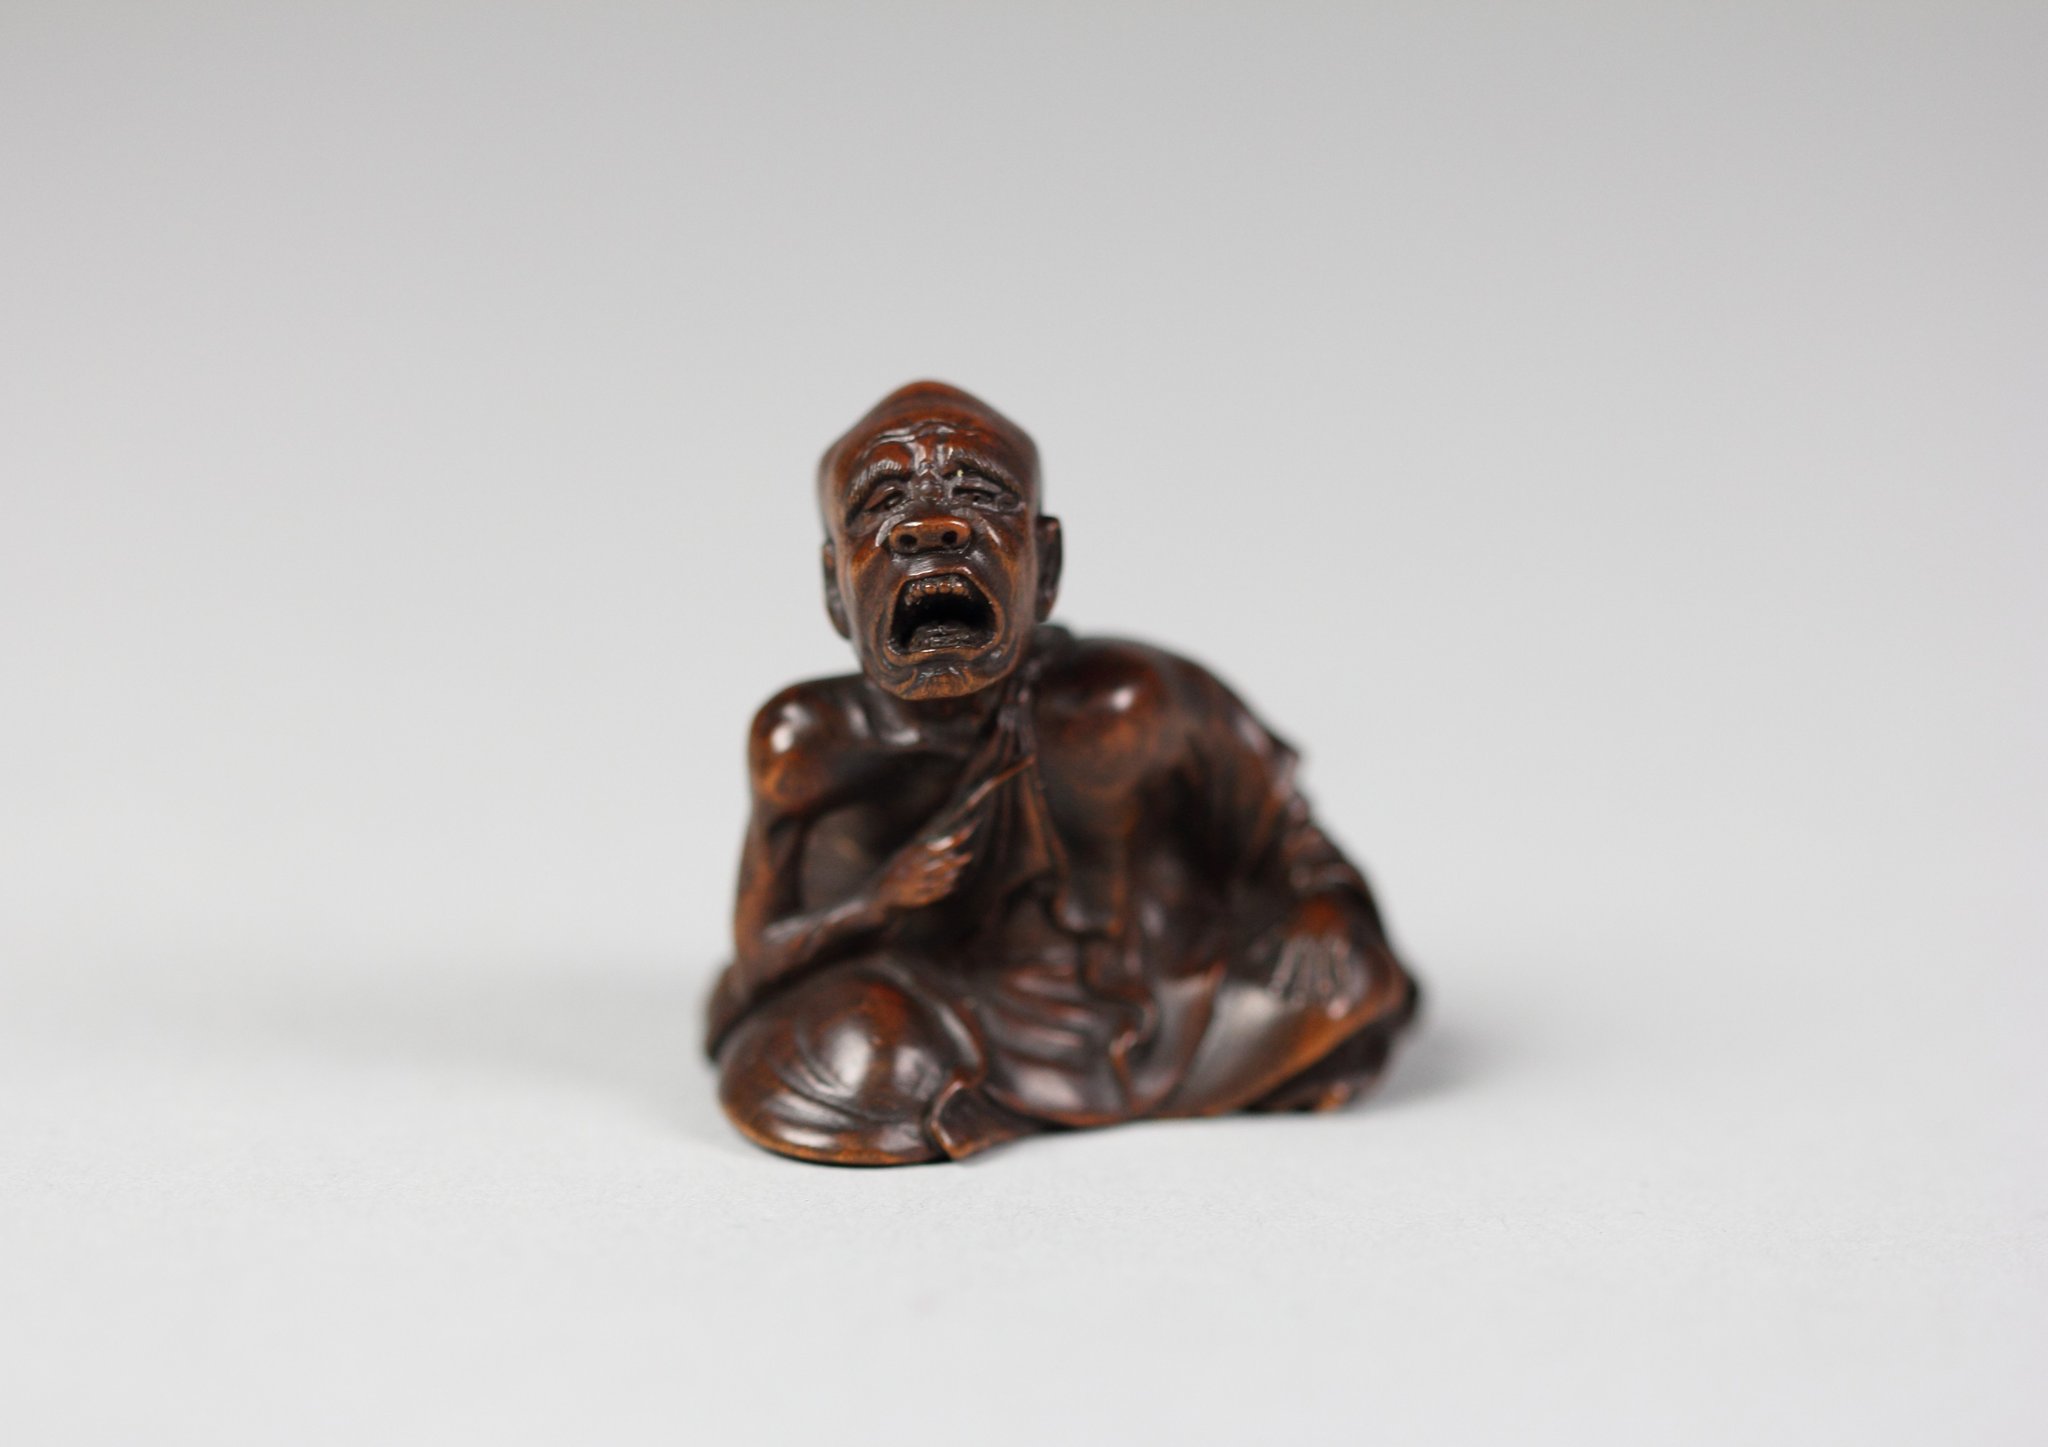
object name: netsuke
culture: japanese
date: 1801-1900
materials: wood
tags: men